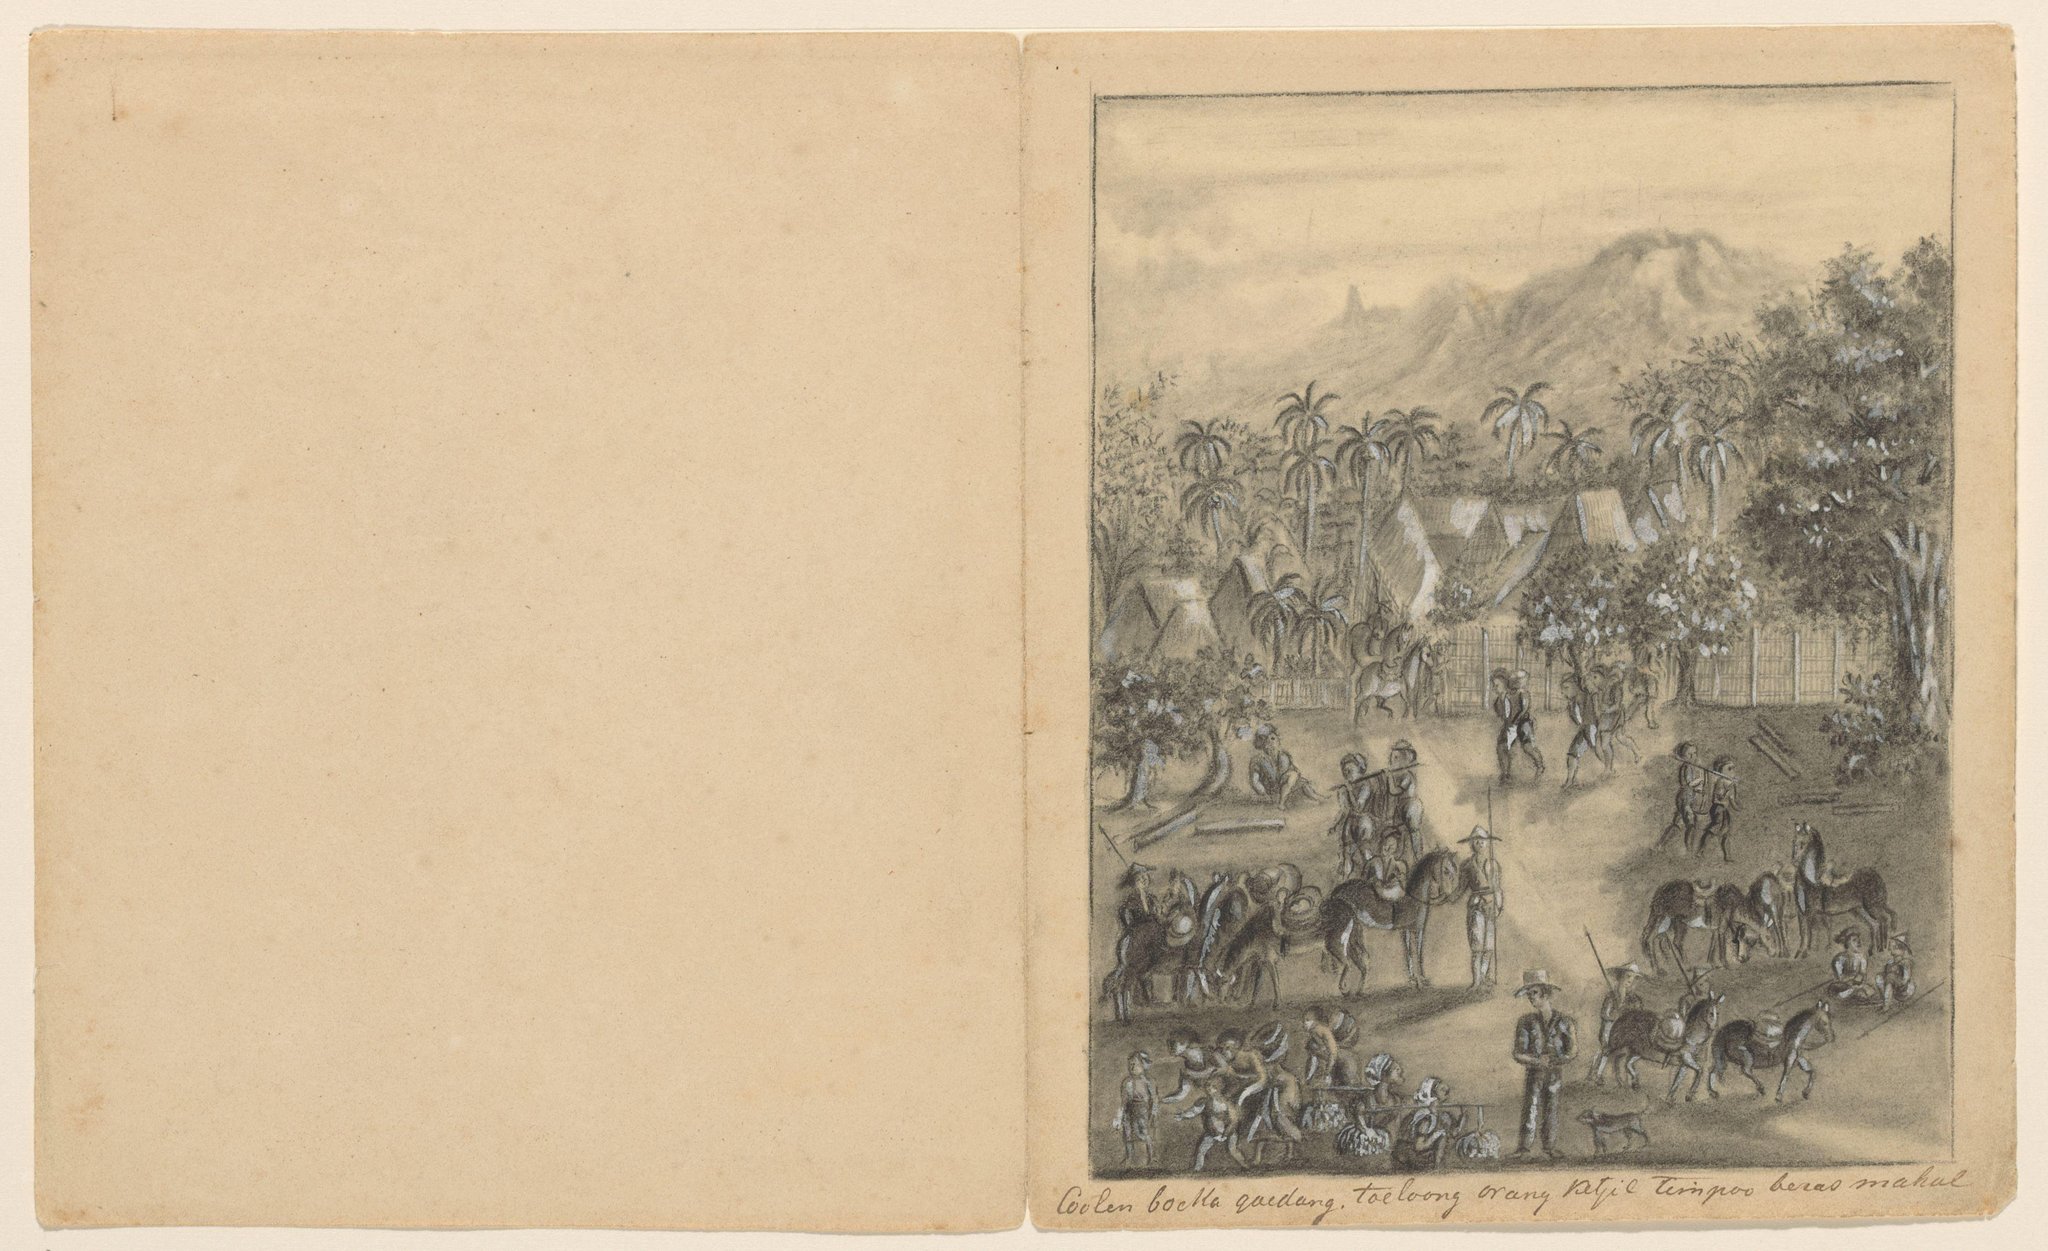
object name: drawing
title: Coolen opent de voorraadschuur met rijst om de kleine man te helpen, ca. 1820-1850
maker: Anonymous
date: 1850-1950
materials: chalk, paper, pencil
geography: indonesia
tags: eruption (of volcano)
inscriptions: collector's mark: Lugt 2228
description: Coolen opent de voorraadschuur met rijst om de kleine man te helpen, als de rijst duur is. Onderdeel van een groep van twaalf losse bladen uit een schetsboek met tekeningen over het leven van Coenraad Laurens Coolen, evangelist op Oost-Java, ca. 1820-1850. Elk blad heeft een tekening op de rechterhelft, met een onderschrift in het Indonesisch.